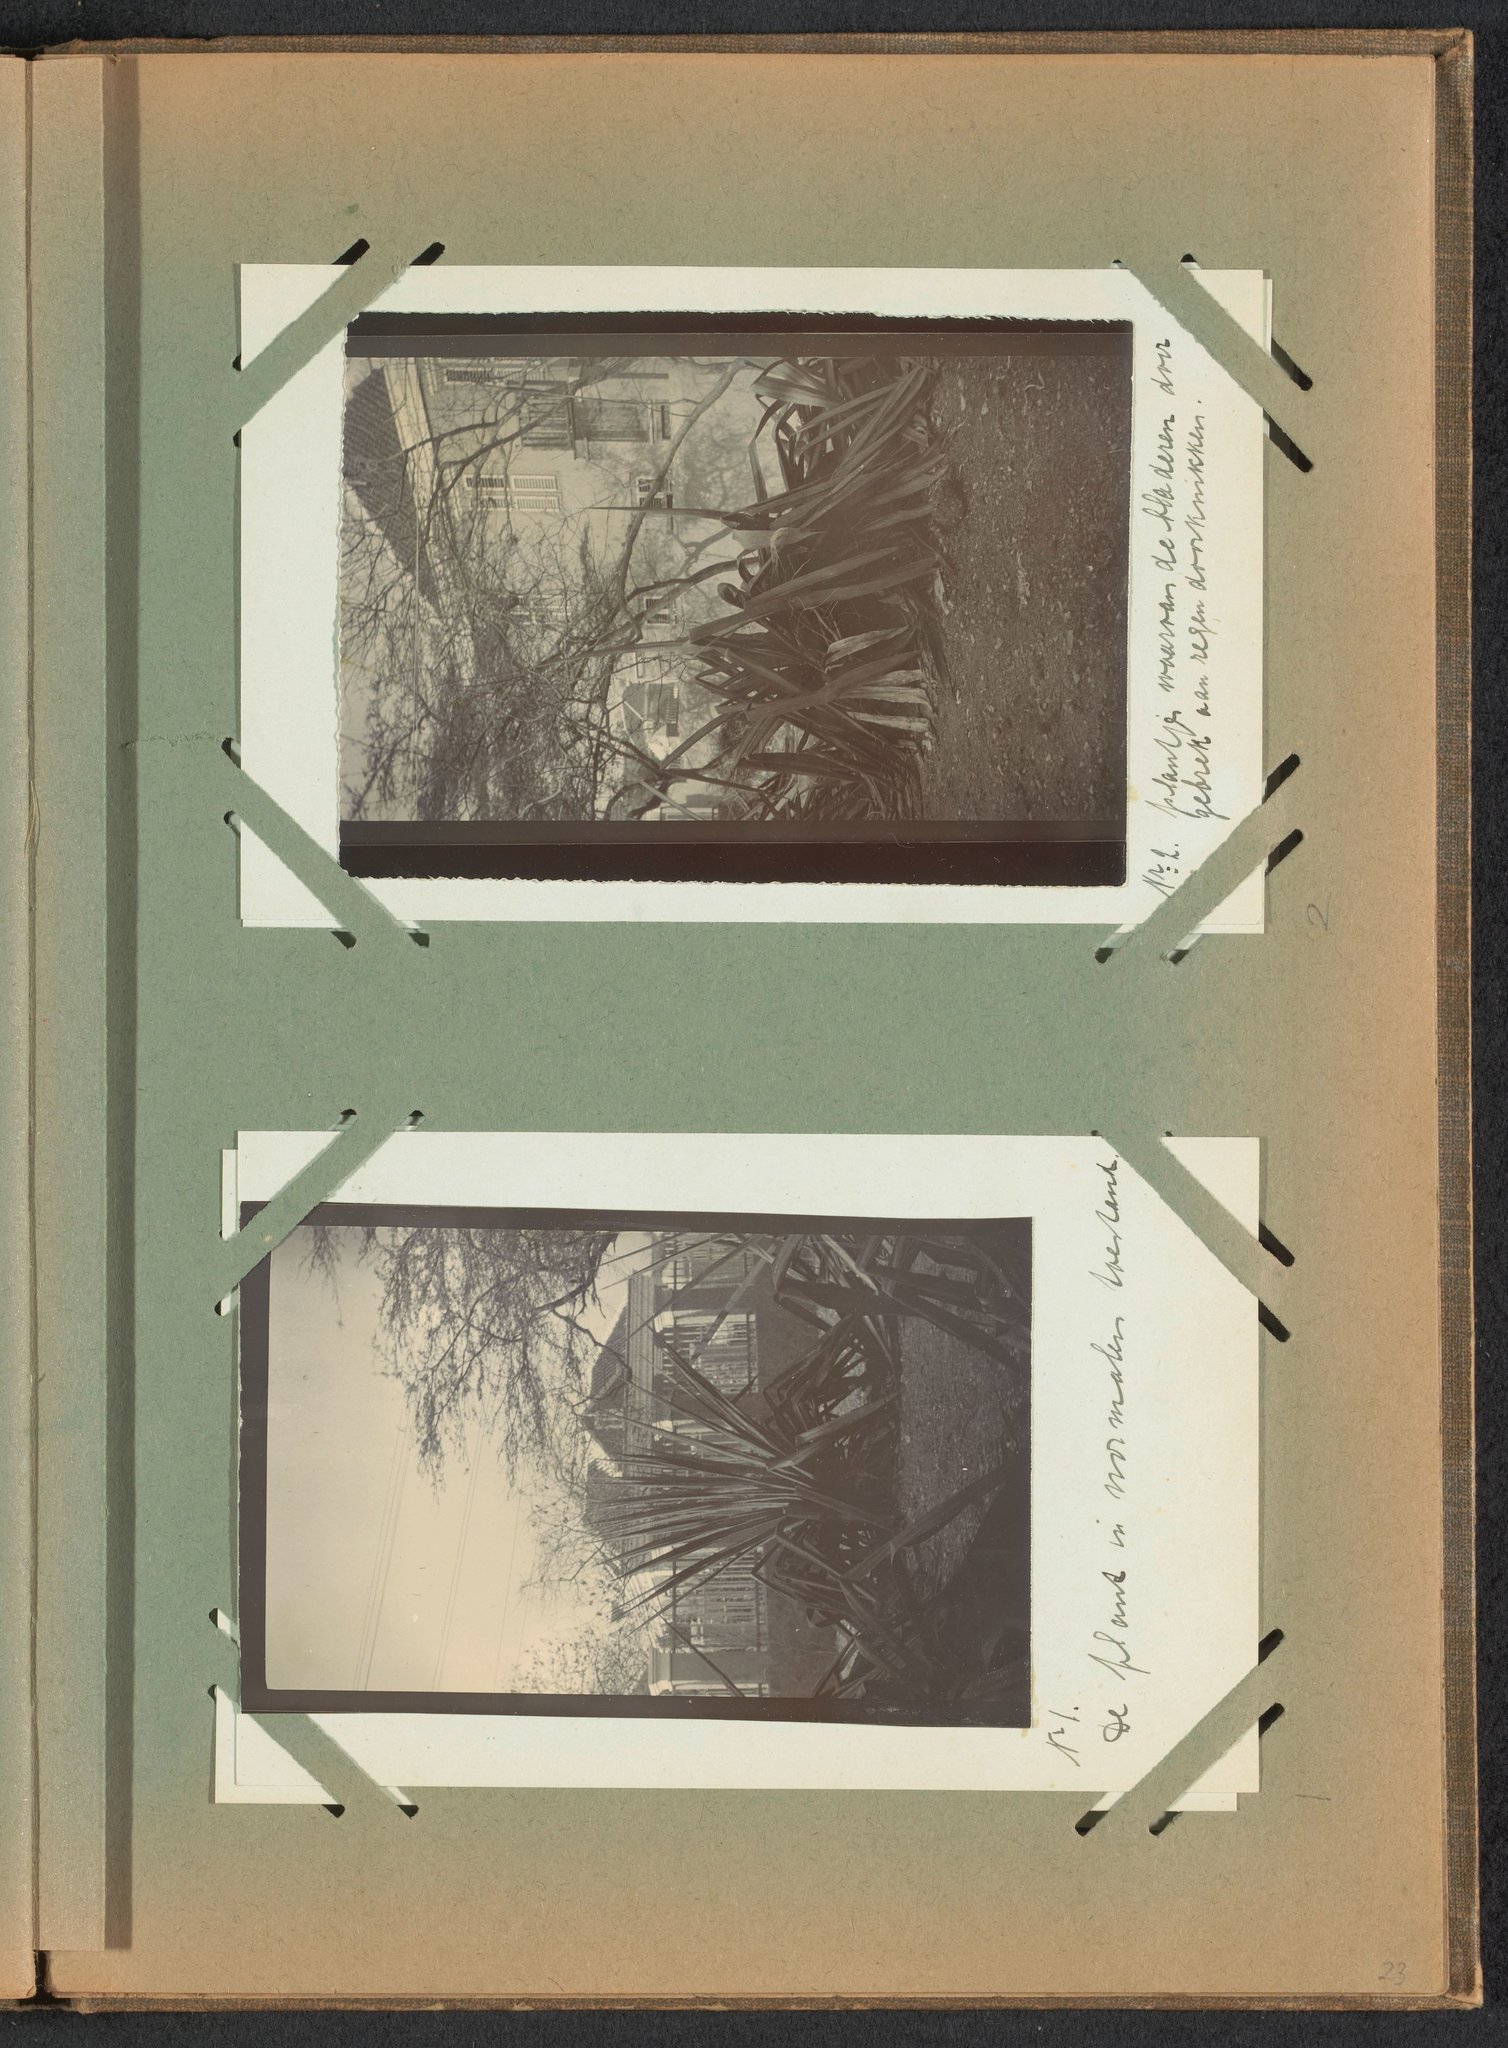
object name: photograph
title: Planten voor een huis op Curaçao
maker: Anonymous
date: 1912-1913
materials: paper, photographic support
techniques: gelatin silver print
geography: curacao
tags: plantation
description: Verlepte planten voor een huis op Curaçao. Onderdeel van het fotoalbum uit ca. 1912-1913 met 92 foto's van de plantages Peperpot en Dordrecht in Suriname en Mount Pleasant op Curaçao.